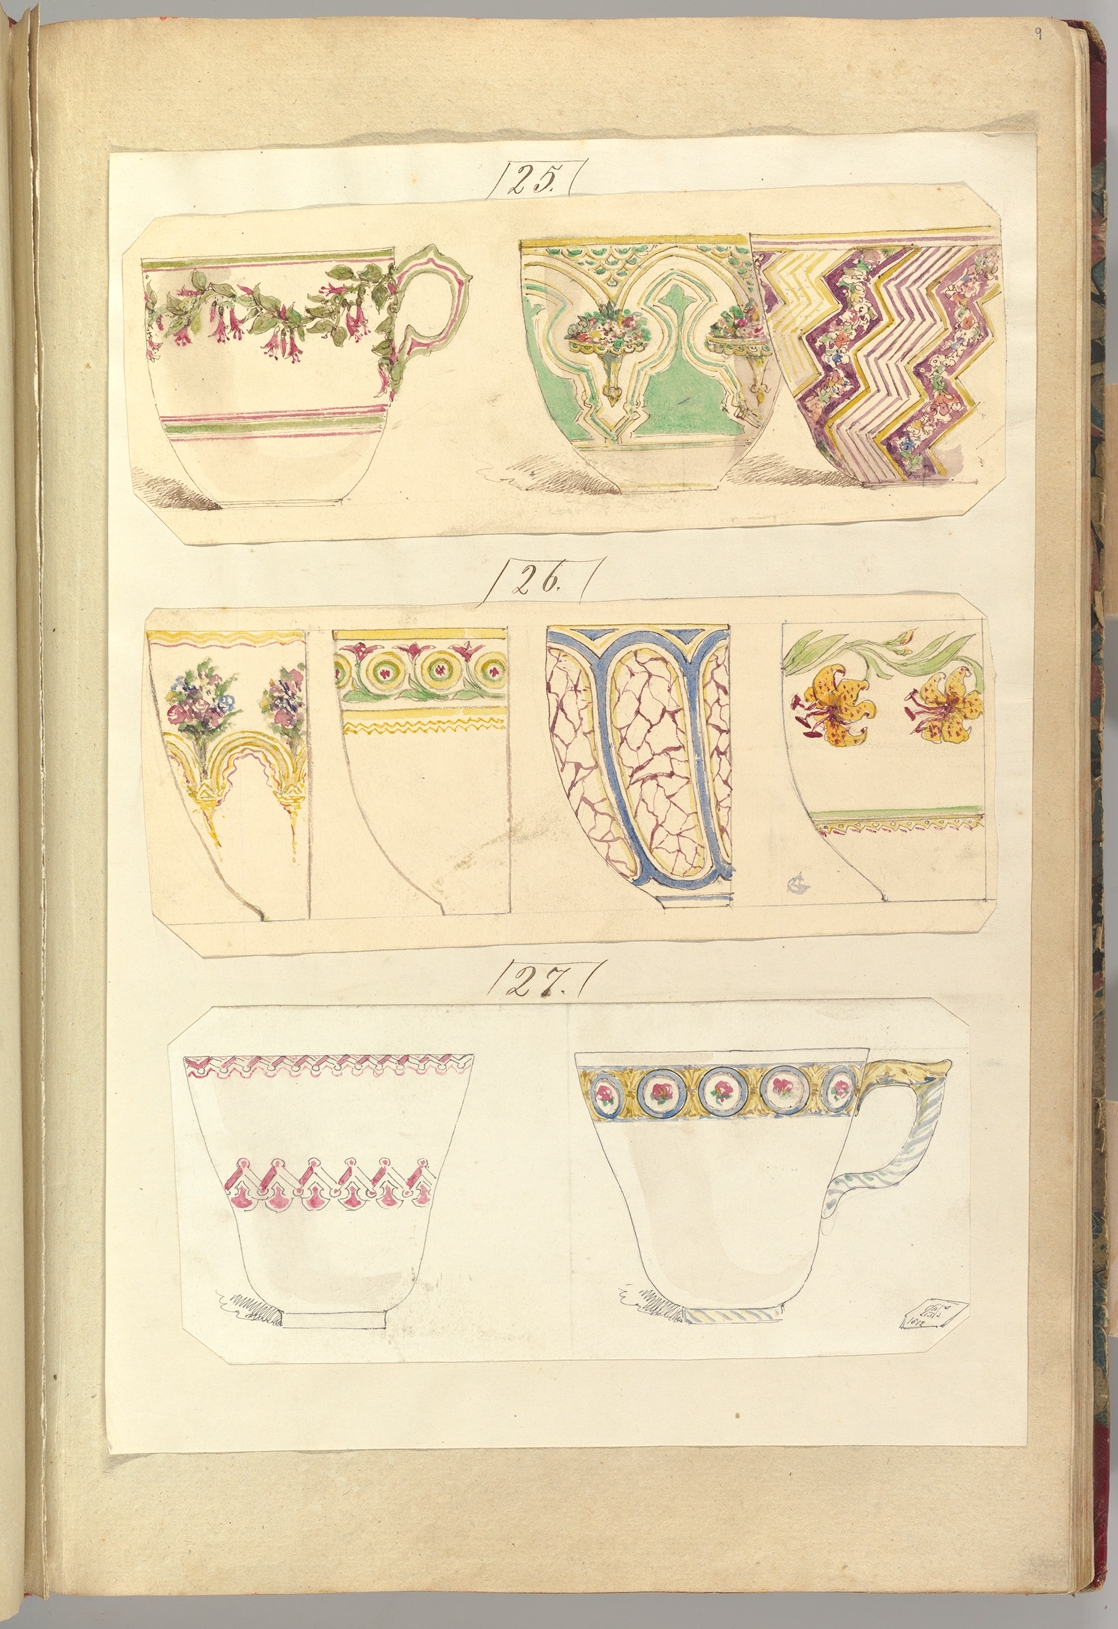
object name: drawing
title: Nine Designs for Decorated Cups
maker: alfred henry forrester [alfred crowquill]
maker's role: artist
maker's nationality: british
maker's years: 1804-1872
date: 1852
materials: gouache, ink, watercolor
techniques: pen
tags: flowers,leaves,cups